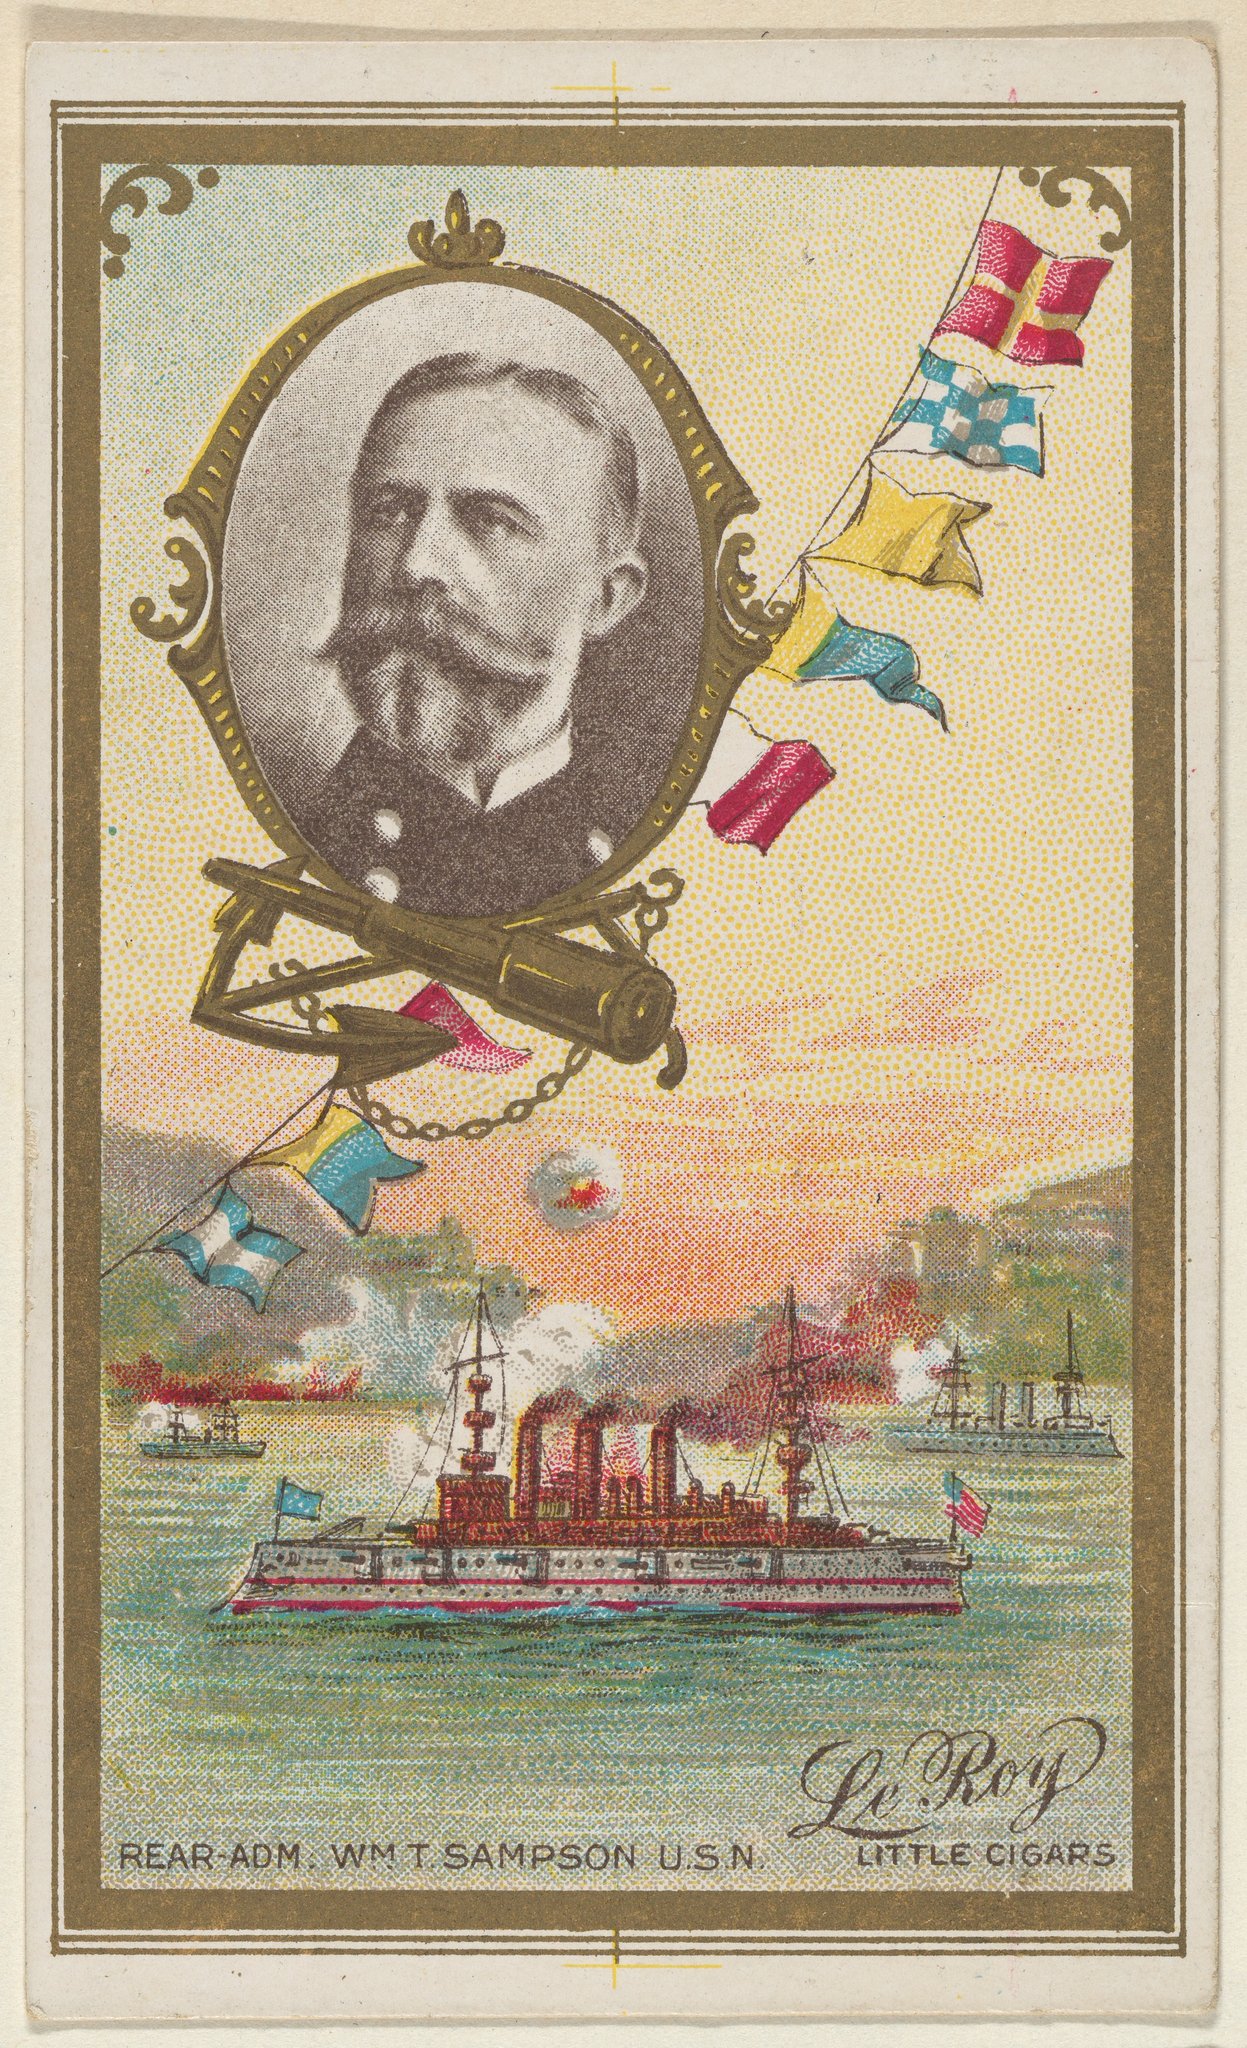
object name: print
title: Rear Admiral William T. Sampson, U.S. Navy, from the "Generals" series (T63), issued by LeRoy Little Cigars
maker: leroy little cigars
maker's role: publisher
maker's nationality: american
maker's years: 1850-1950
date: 1898-1901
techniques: color lithograph